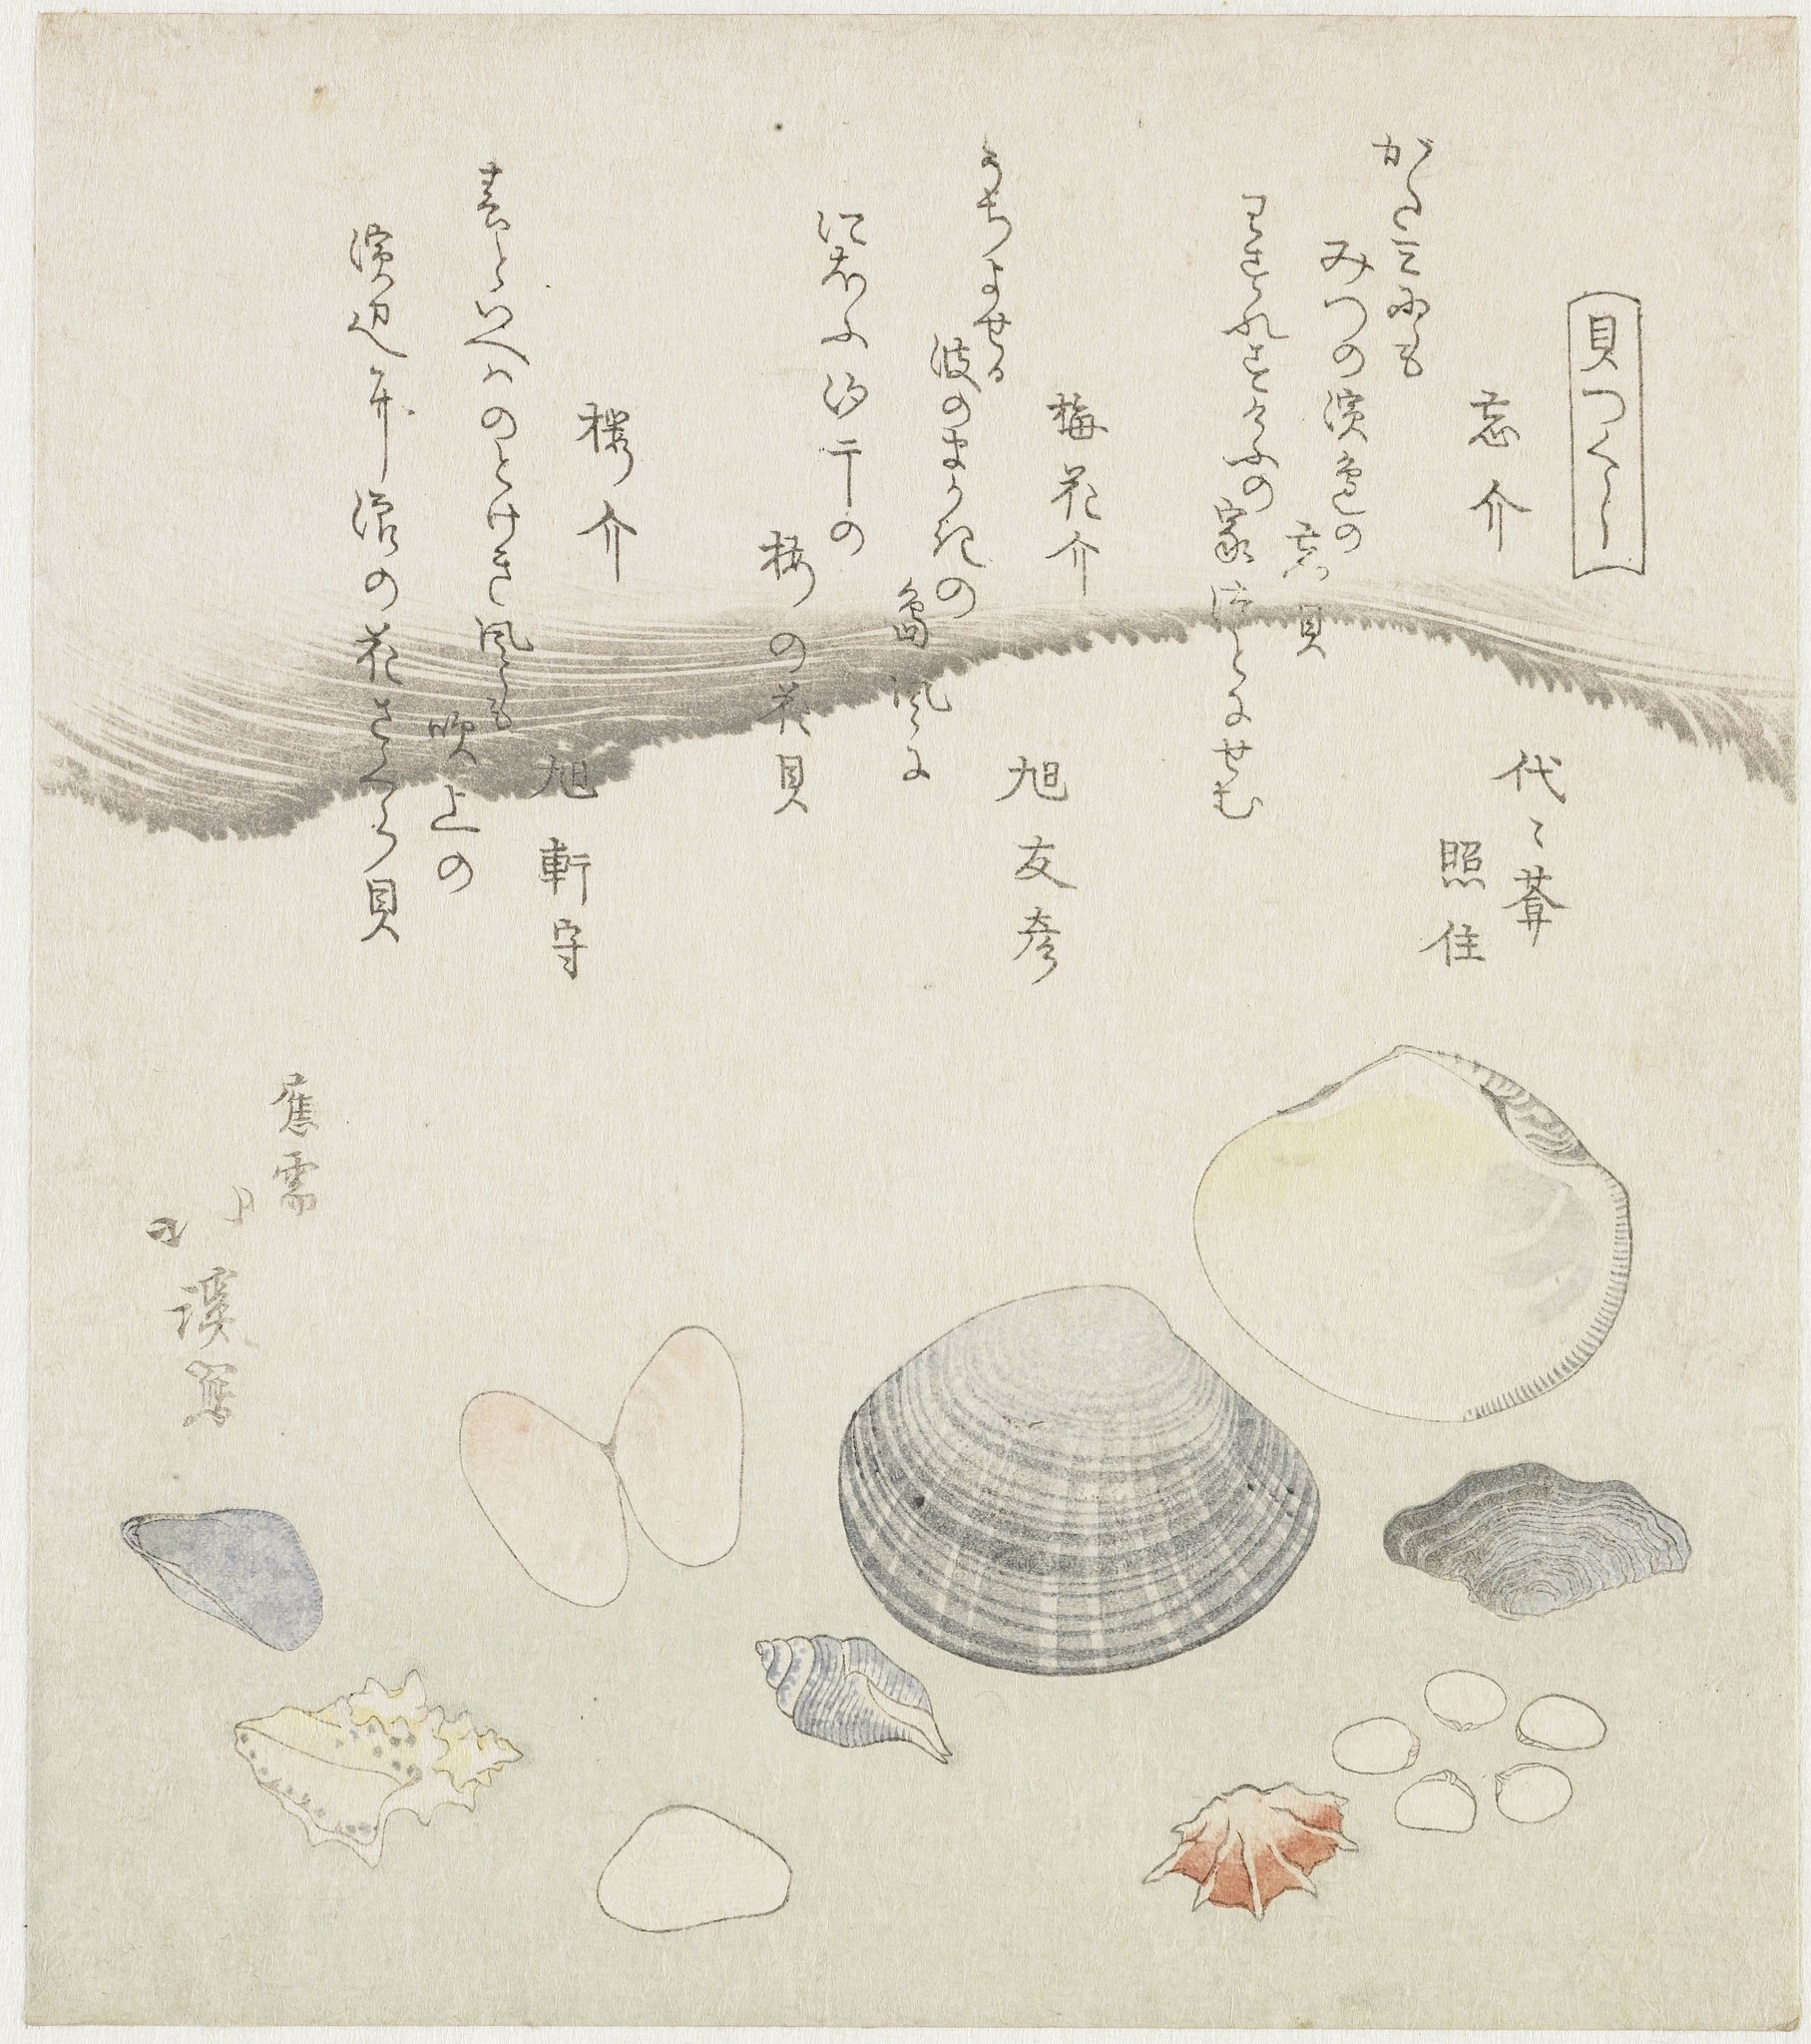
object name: print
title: Vergeten schelp, pruimenbloesem schelp en kersen schelp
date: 1821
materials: paper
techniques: blind stamped, woodcut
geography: japan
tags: molluscs (+ shell, snail-shell etc.)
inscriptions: collector's mark, passe-partout, bottom left, printed: JABdH with a rooster., collector's mark, verso, stamped: Lugt 2228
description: Een surimono is een luxe uitgevoerde prent waarop beeld met één of meerdere gedichten gecombineerd is. Bij het drukken van een surimono werd vaak gebruik gemaakt van dikker papier, blinddruk en metaal pigmenten, zoals koper- en zilverpoeder. De prenten werden vaak in opdracht van dichters gemaakt en als exclusief geschenk aan vrienden en relaties gegeven.